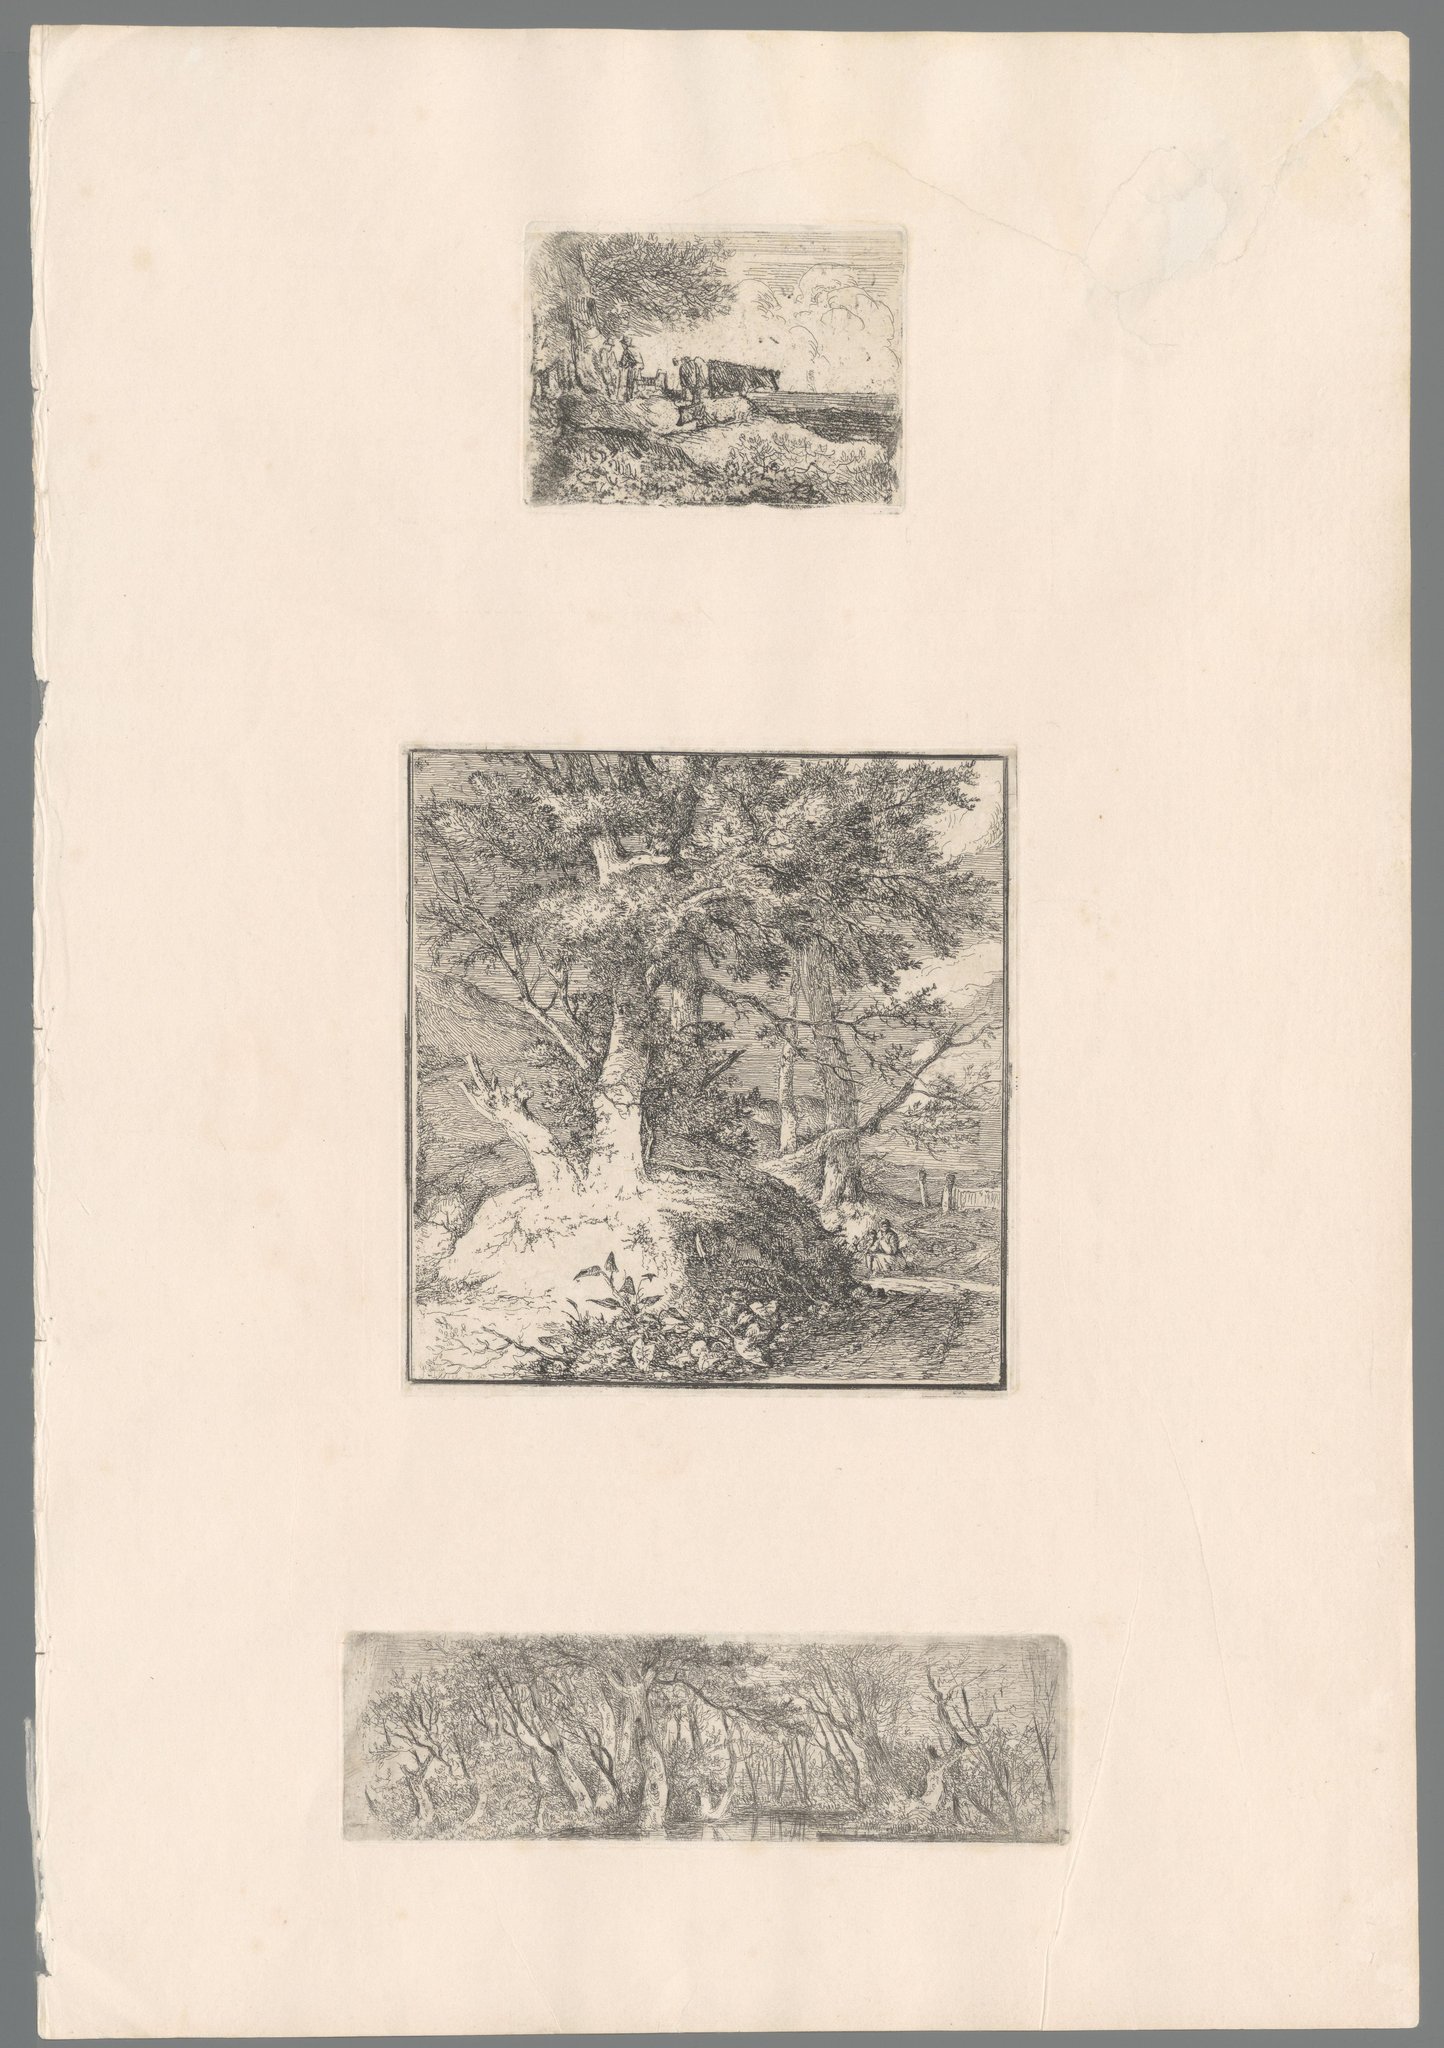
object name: print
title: Landschappen in Norfolk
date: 1834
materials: paper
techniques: etching, intaglio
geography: norwich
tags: trees, pool, puddle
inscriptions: collector's mark: Lugt 2228, collector's mark: Lugt 2760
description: Prent staat samen met RP-P-1973-182 en RP-P-1973-183 op een onversneden blad.